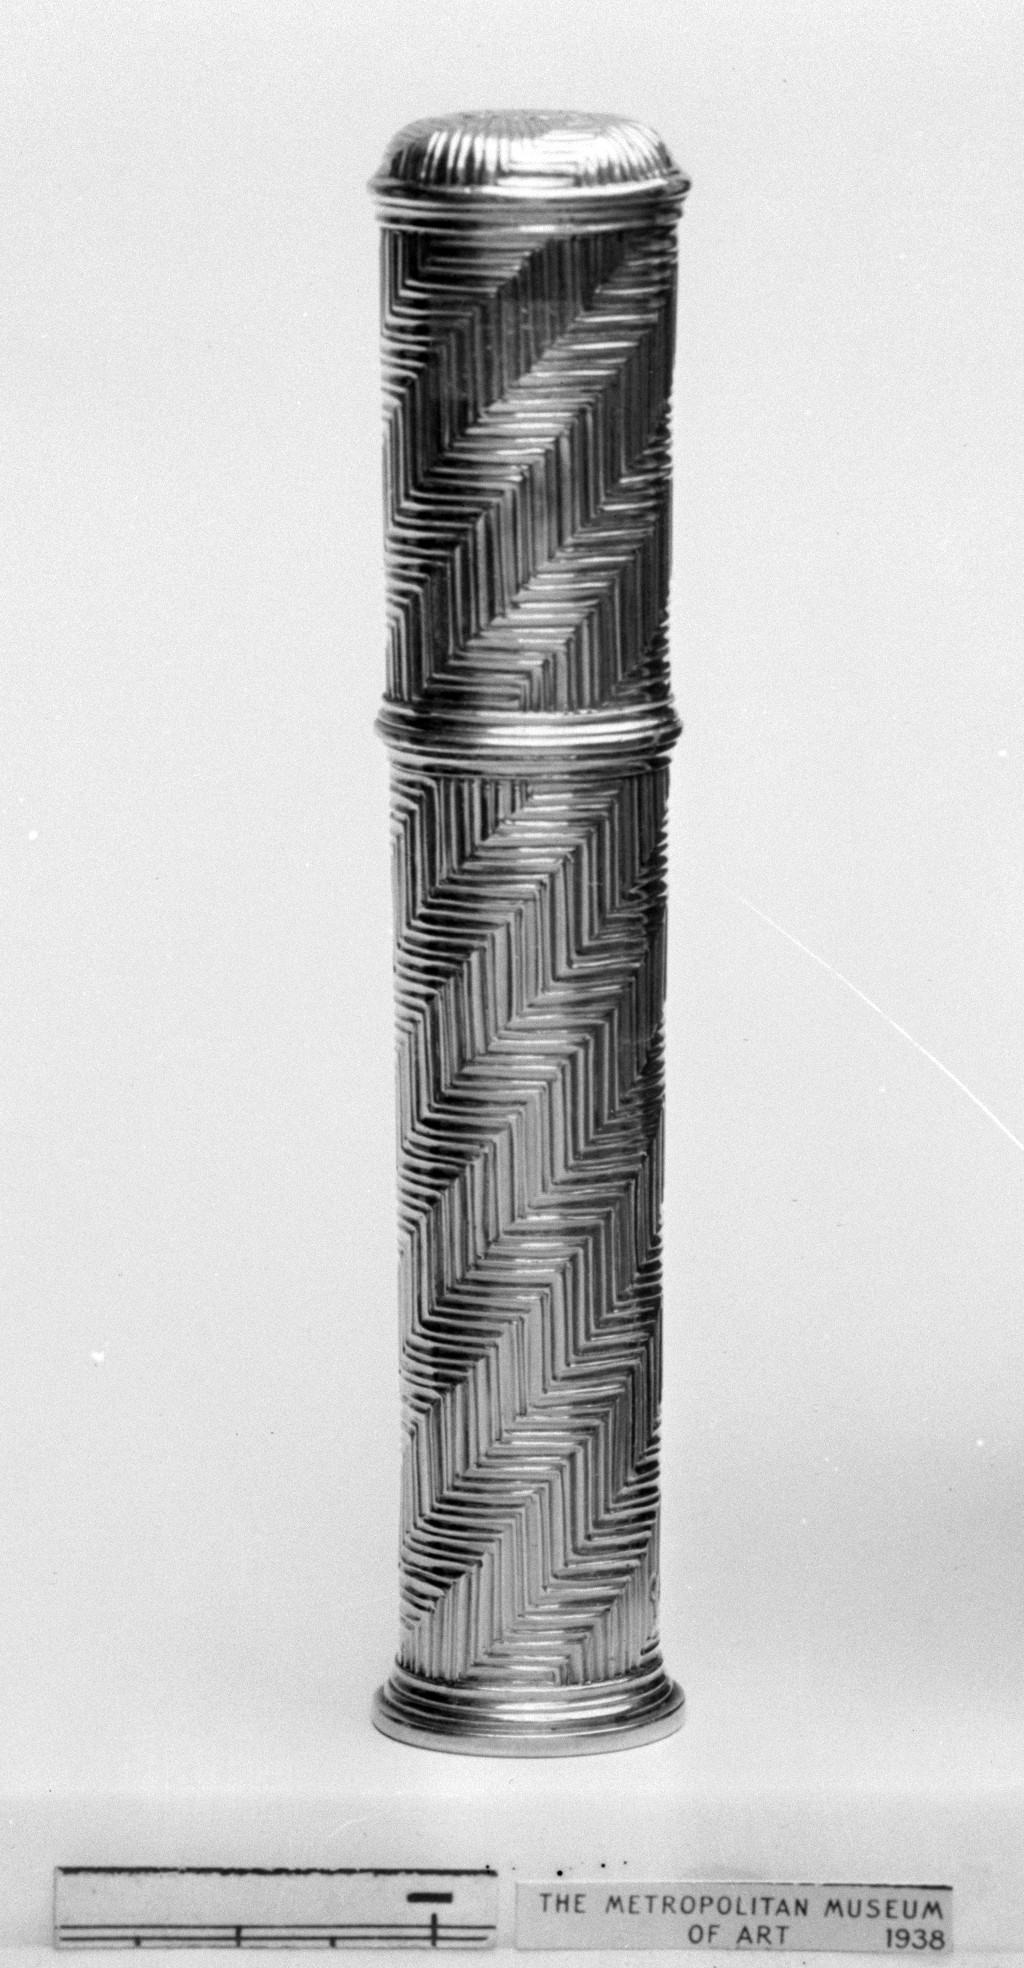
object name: étui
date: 1744-1745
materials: gold